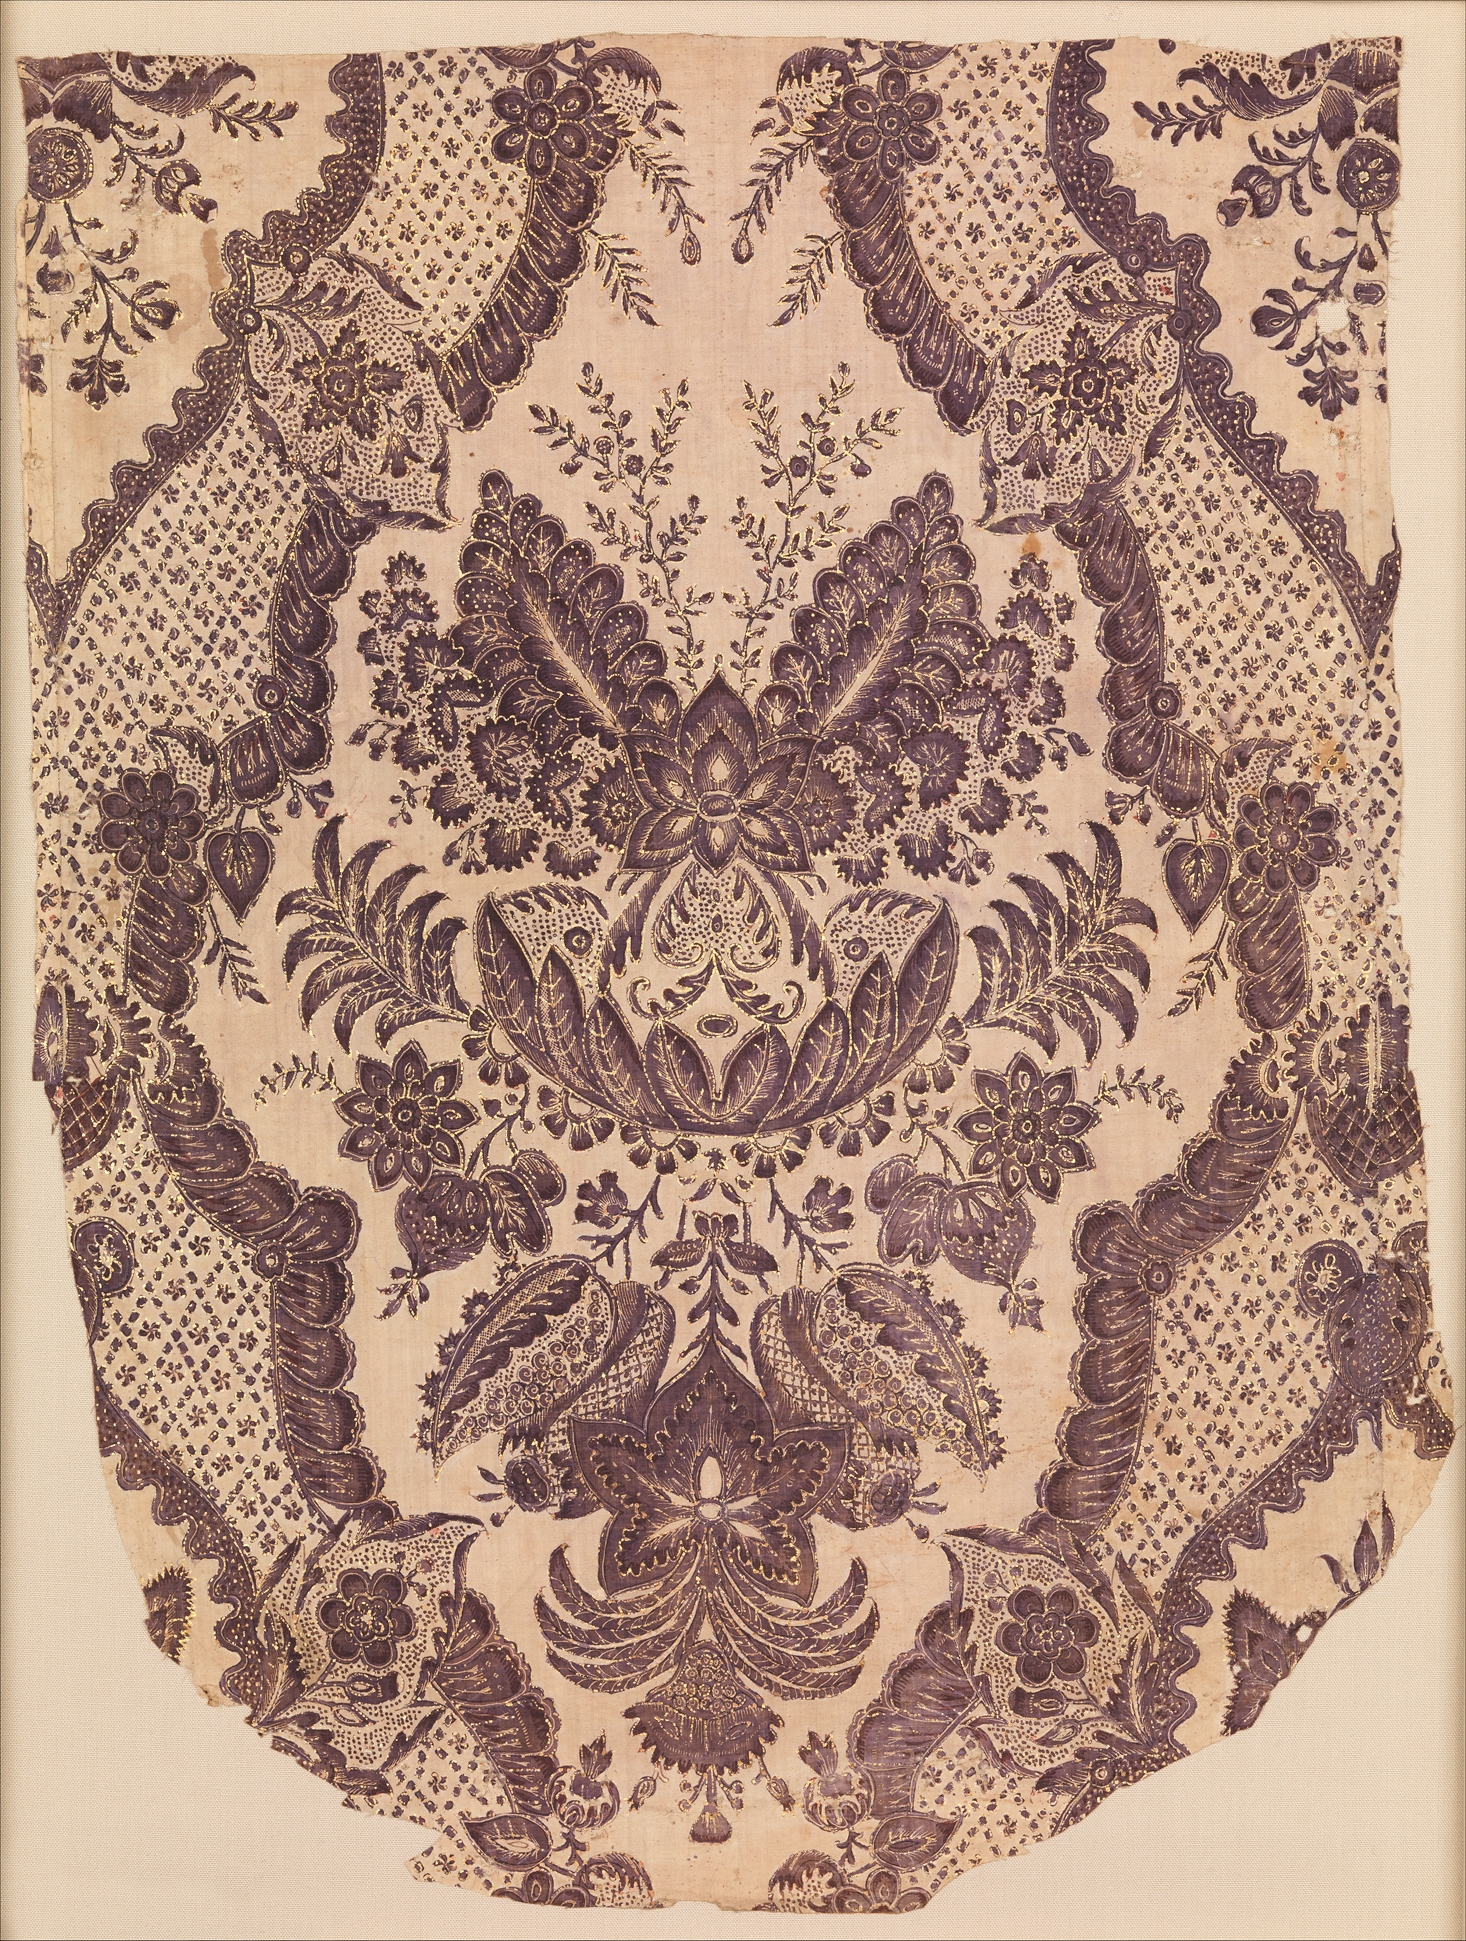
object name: textile fragment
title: Textile Panel of Chintz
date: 1701-1800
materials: cotton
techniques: printing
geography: india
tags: flowers,leaves